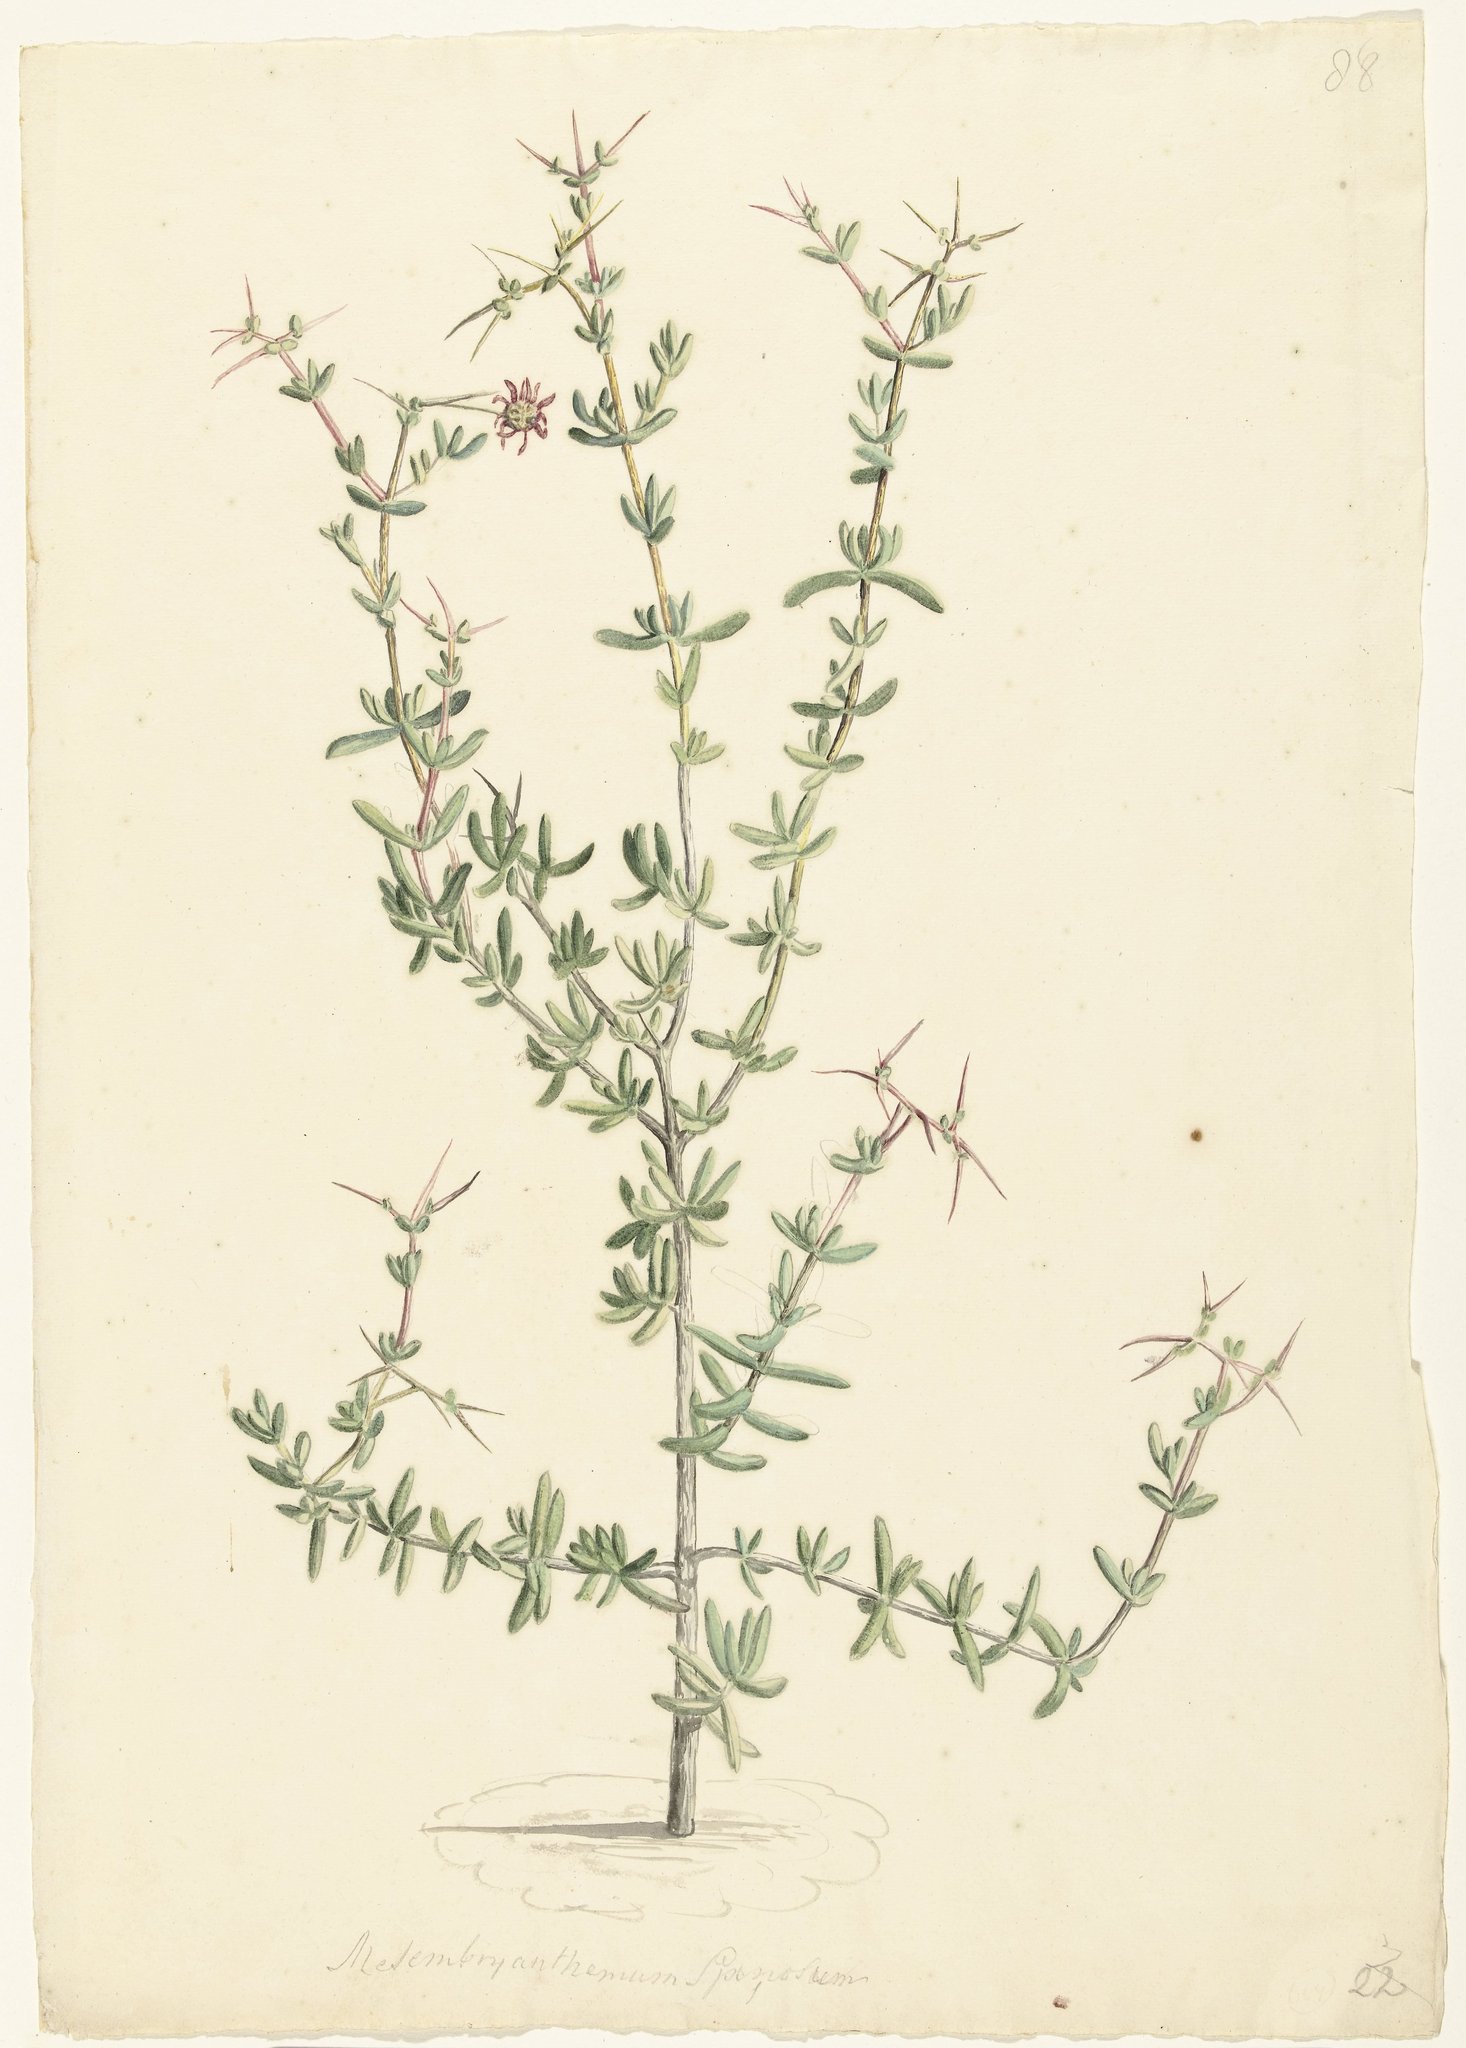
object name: drawing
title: Mesembryanthemum spinosum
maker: laurens vincentsz. van der vinne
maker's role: draughtsman, print maker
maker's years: 1658-1729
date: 1668-1729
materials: paper, watercolor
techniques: brush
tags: plants and herbs: mesembryanthemum